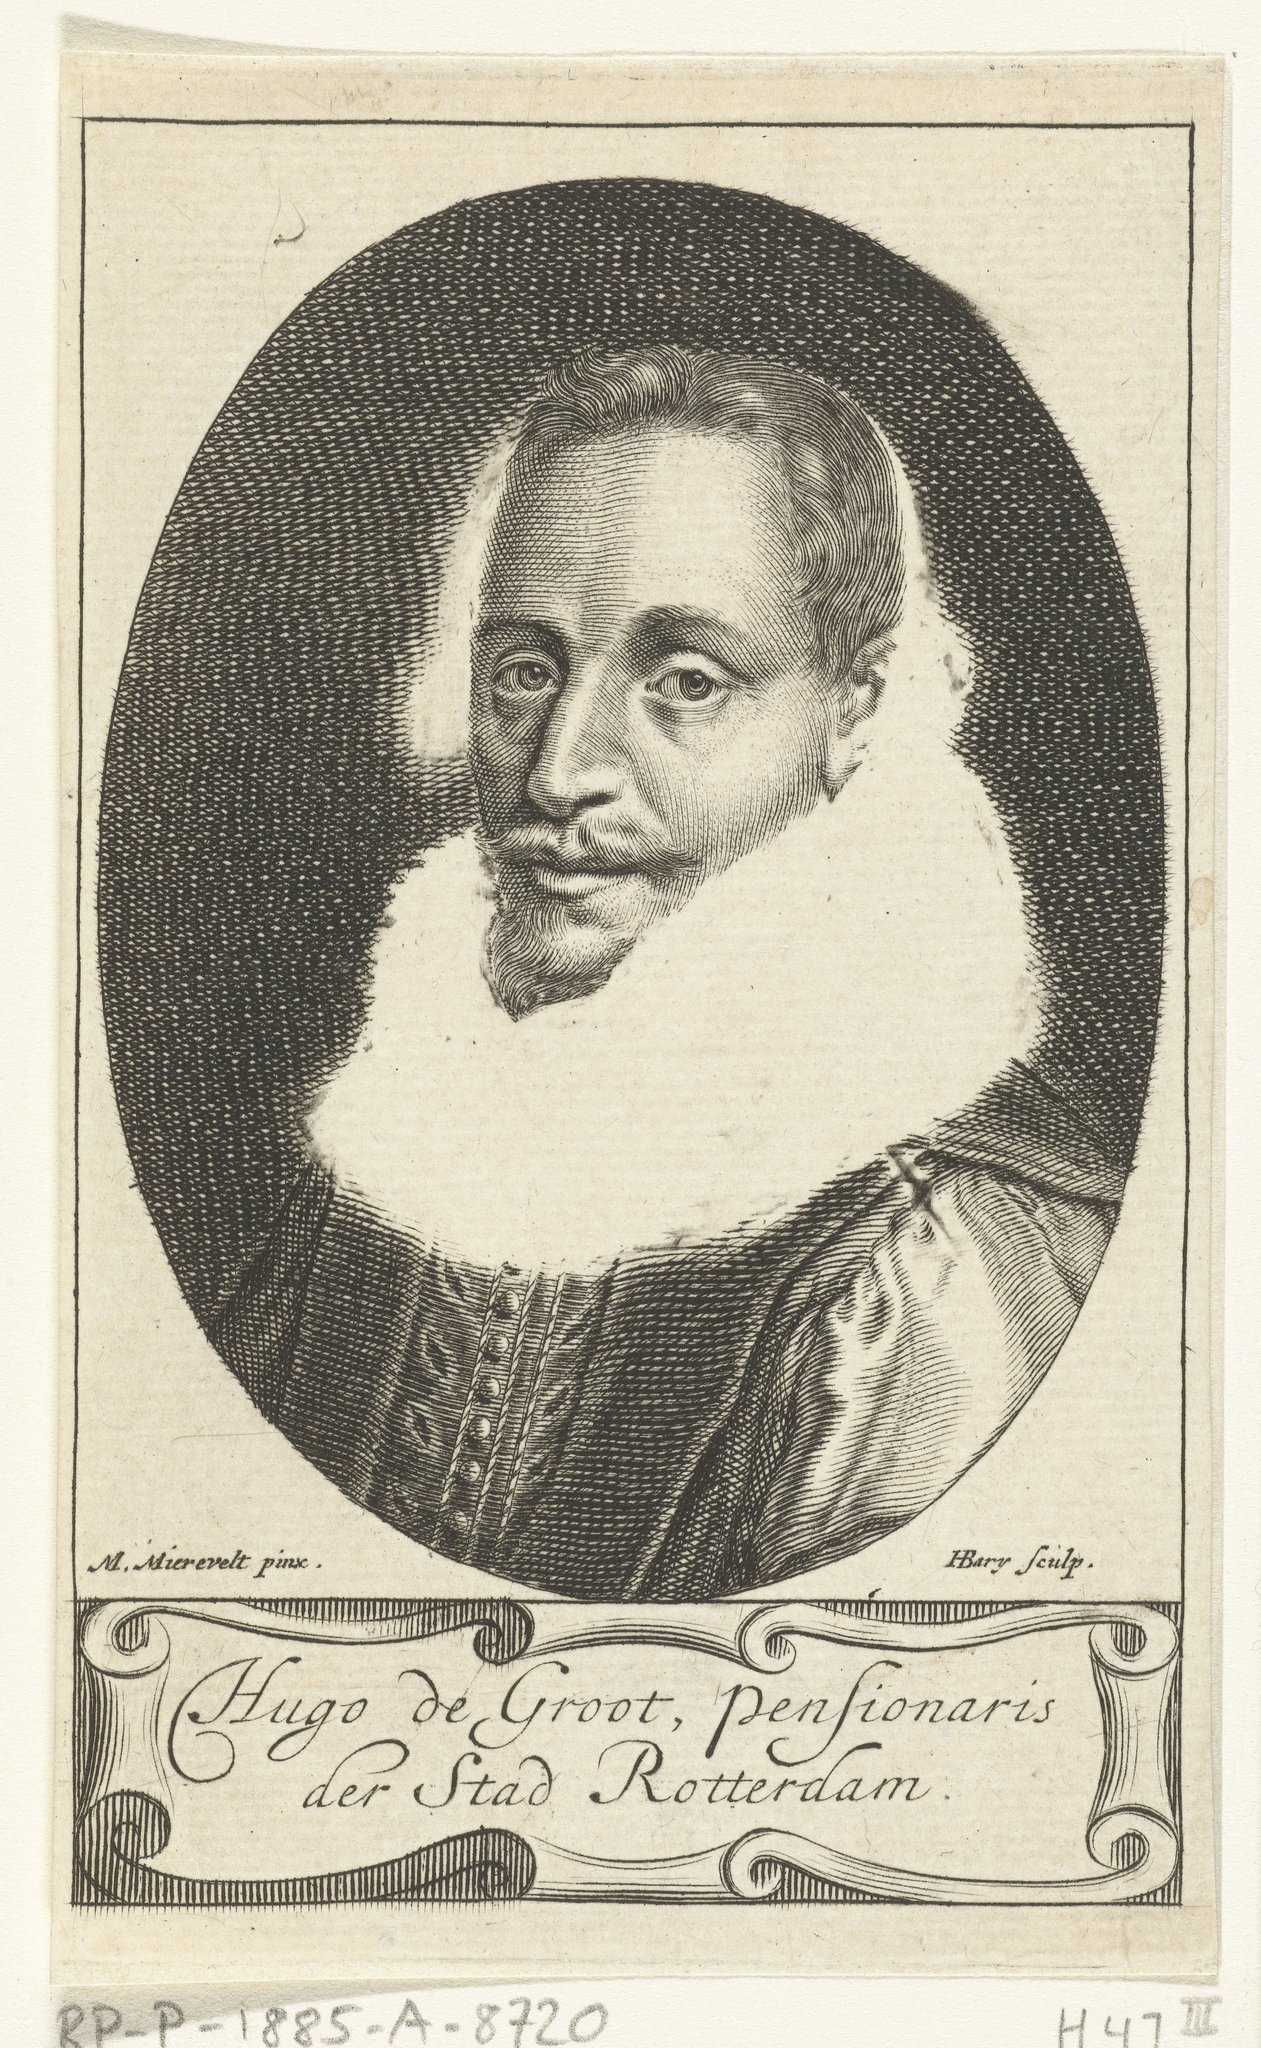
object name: print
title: Portret van Hugo de Groot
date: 1657-1707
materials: paper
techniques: engraving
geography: netherlands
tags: delft, hugo de groot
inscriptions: collector's mark: Lugt 2228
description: Borstbeeld van Hugo de Groot. Onder het portret in een cartouche zijn naam en functie.